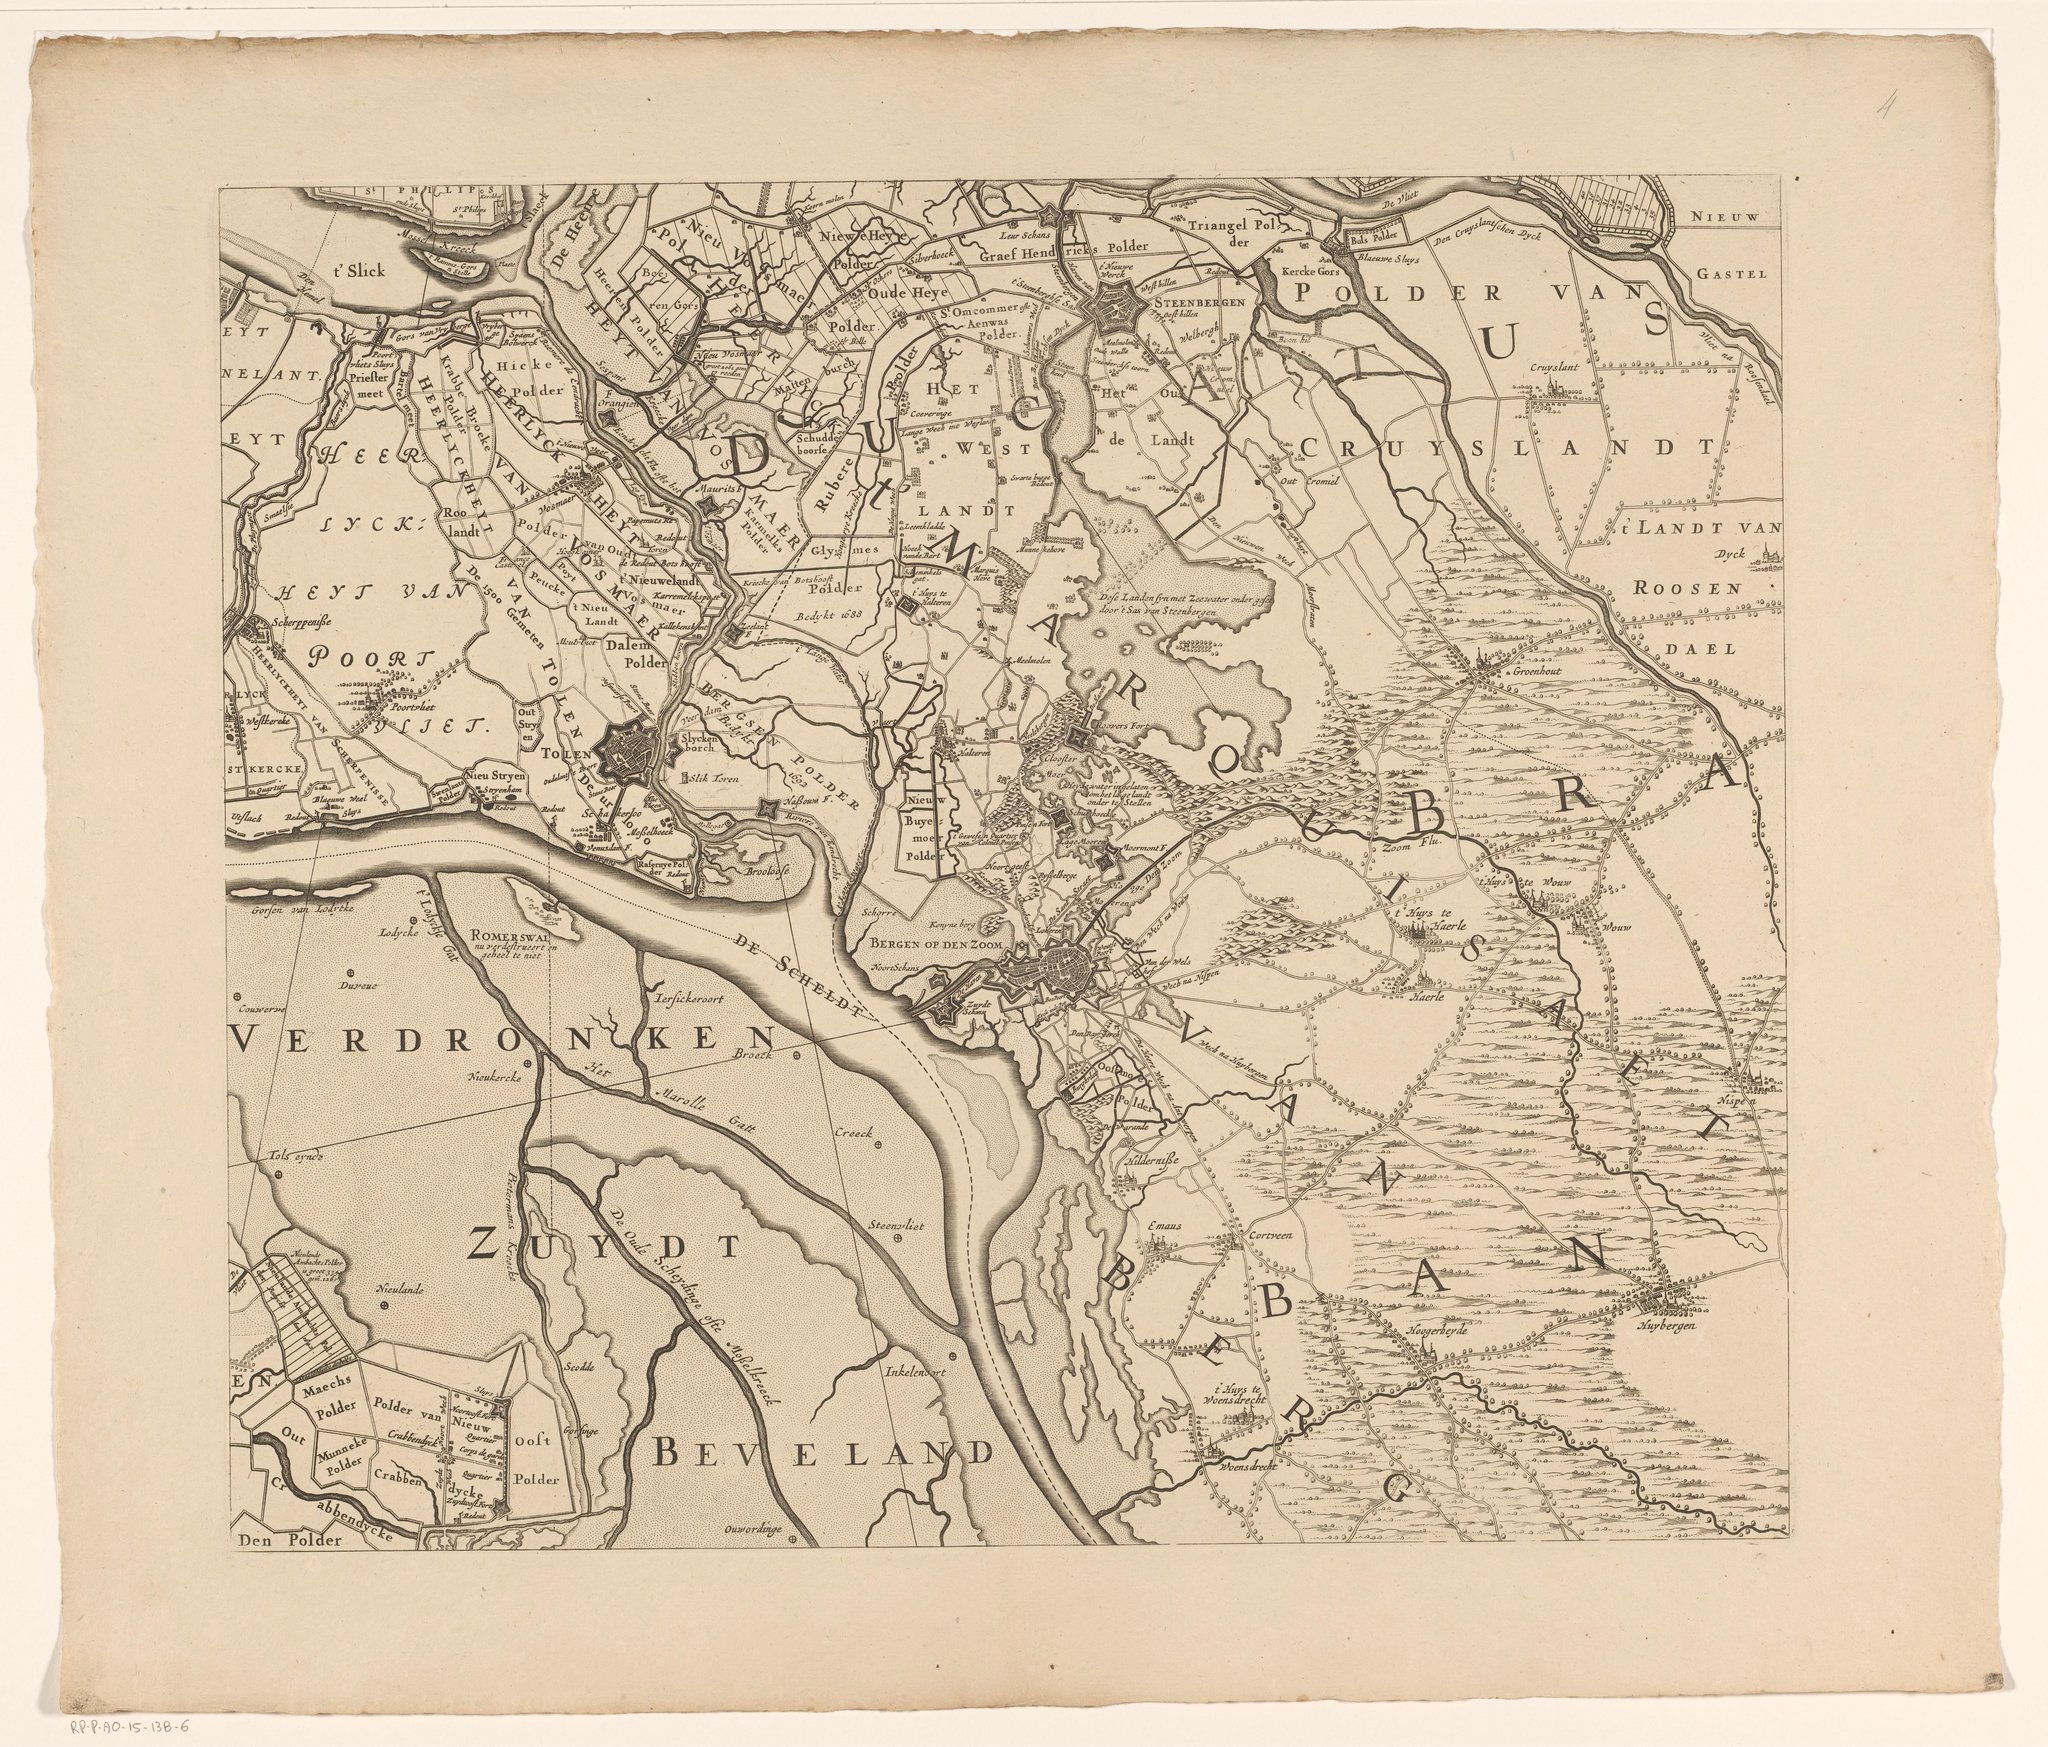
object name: map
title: Kaart van Zeeland (zesde deel)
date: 1655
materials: paper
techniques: engraving, etching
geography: amsterdam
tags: maps of separate countries or regions, zeeland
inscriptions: collector's mark: Lugt 19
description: Zesde deel van een kaart van Zeeland, bestaande uit negen delen. Rechtsonder genummerd: 6.